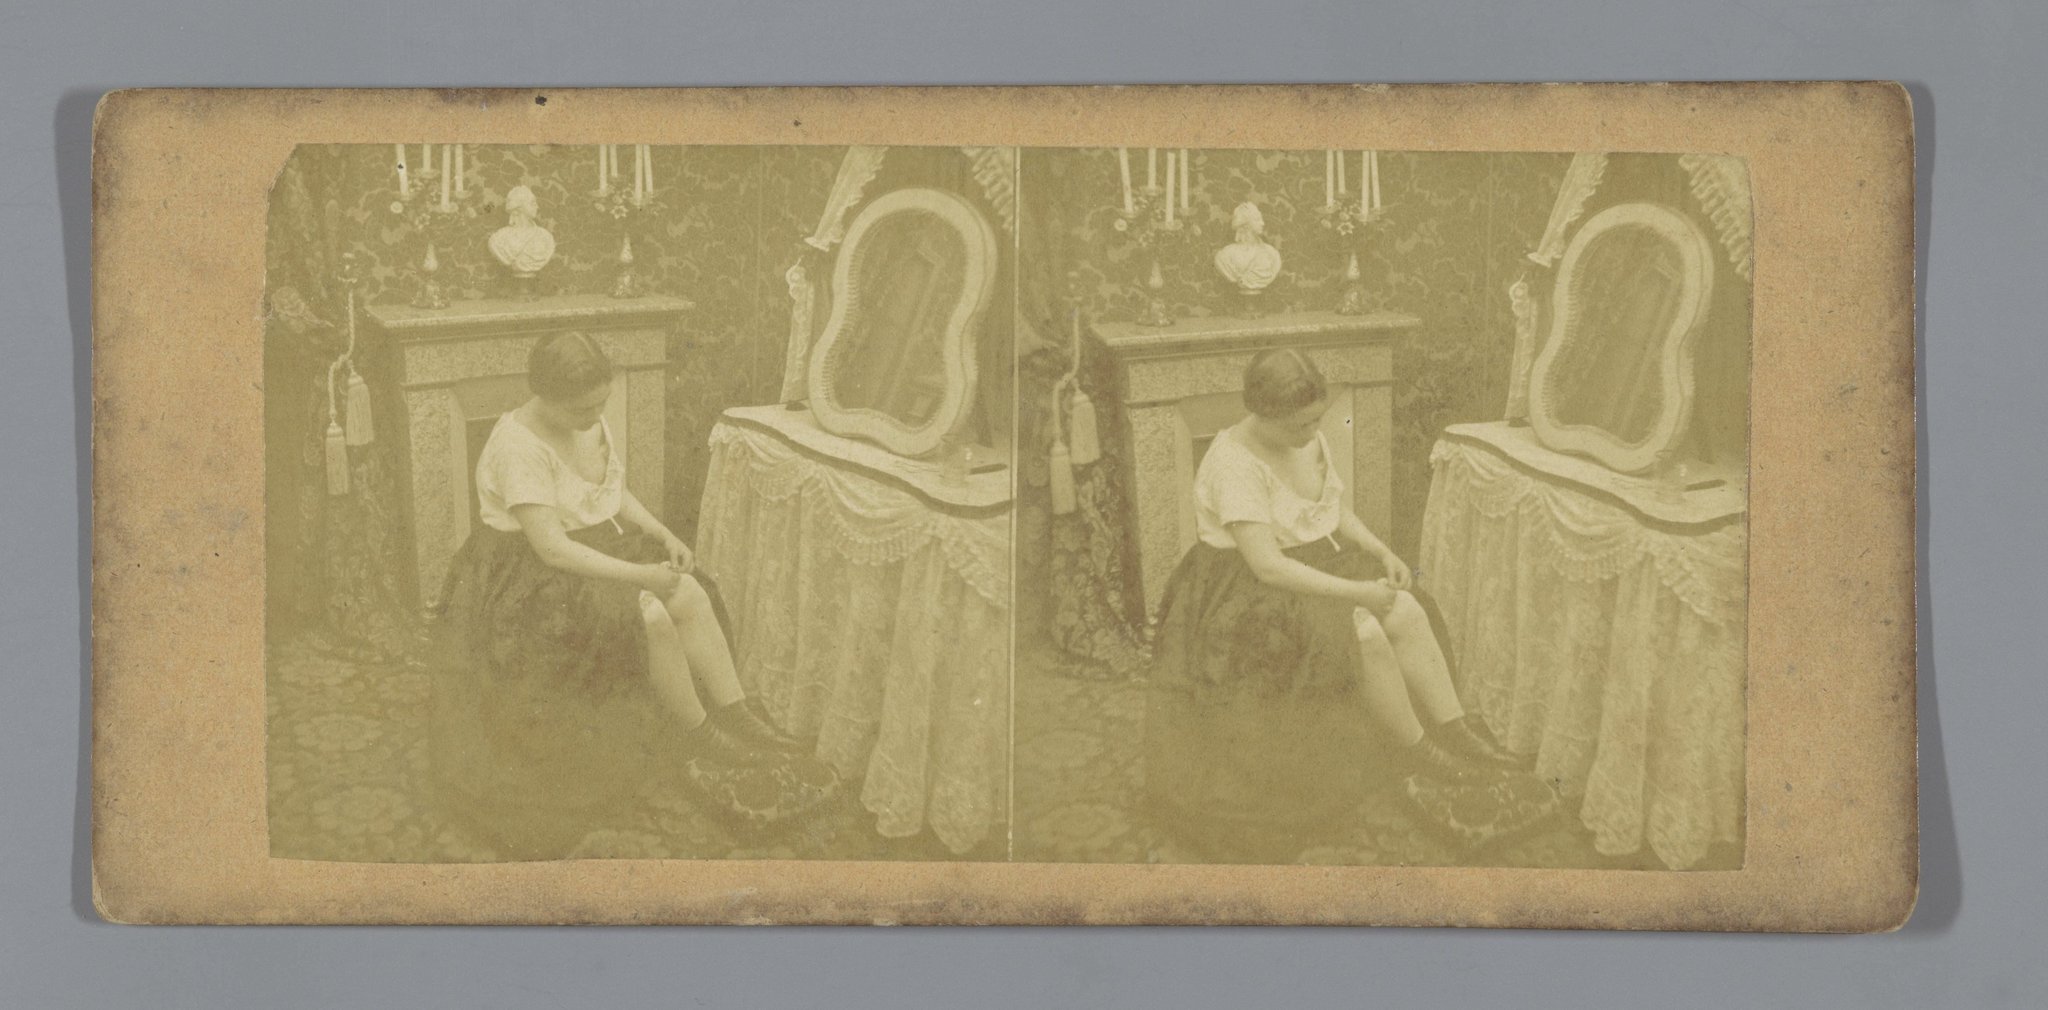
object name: stereograph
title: Tafereel in boudoir: een vrouw trekt kousen aan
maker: Anonymous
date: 1852-1858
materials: cardboard, paper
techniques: albumen print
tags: adult woman